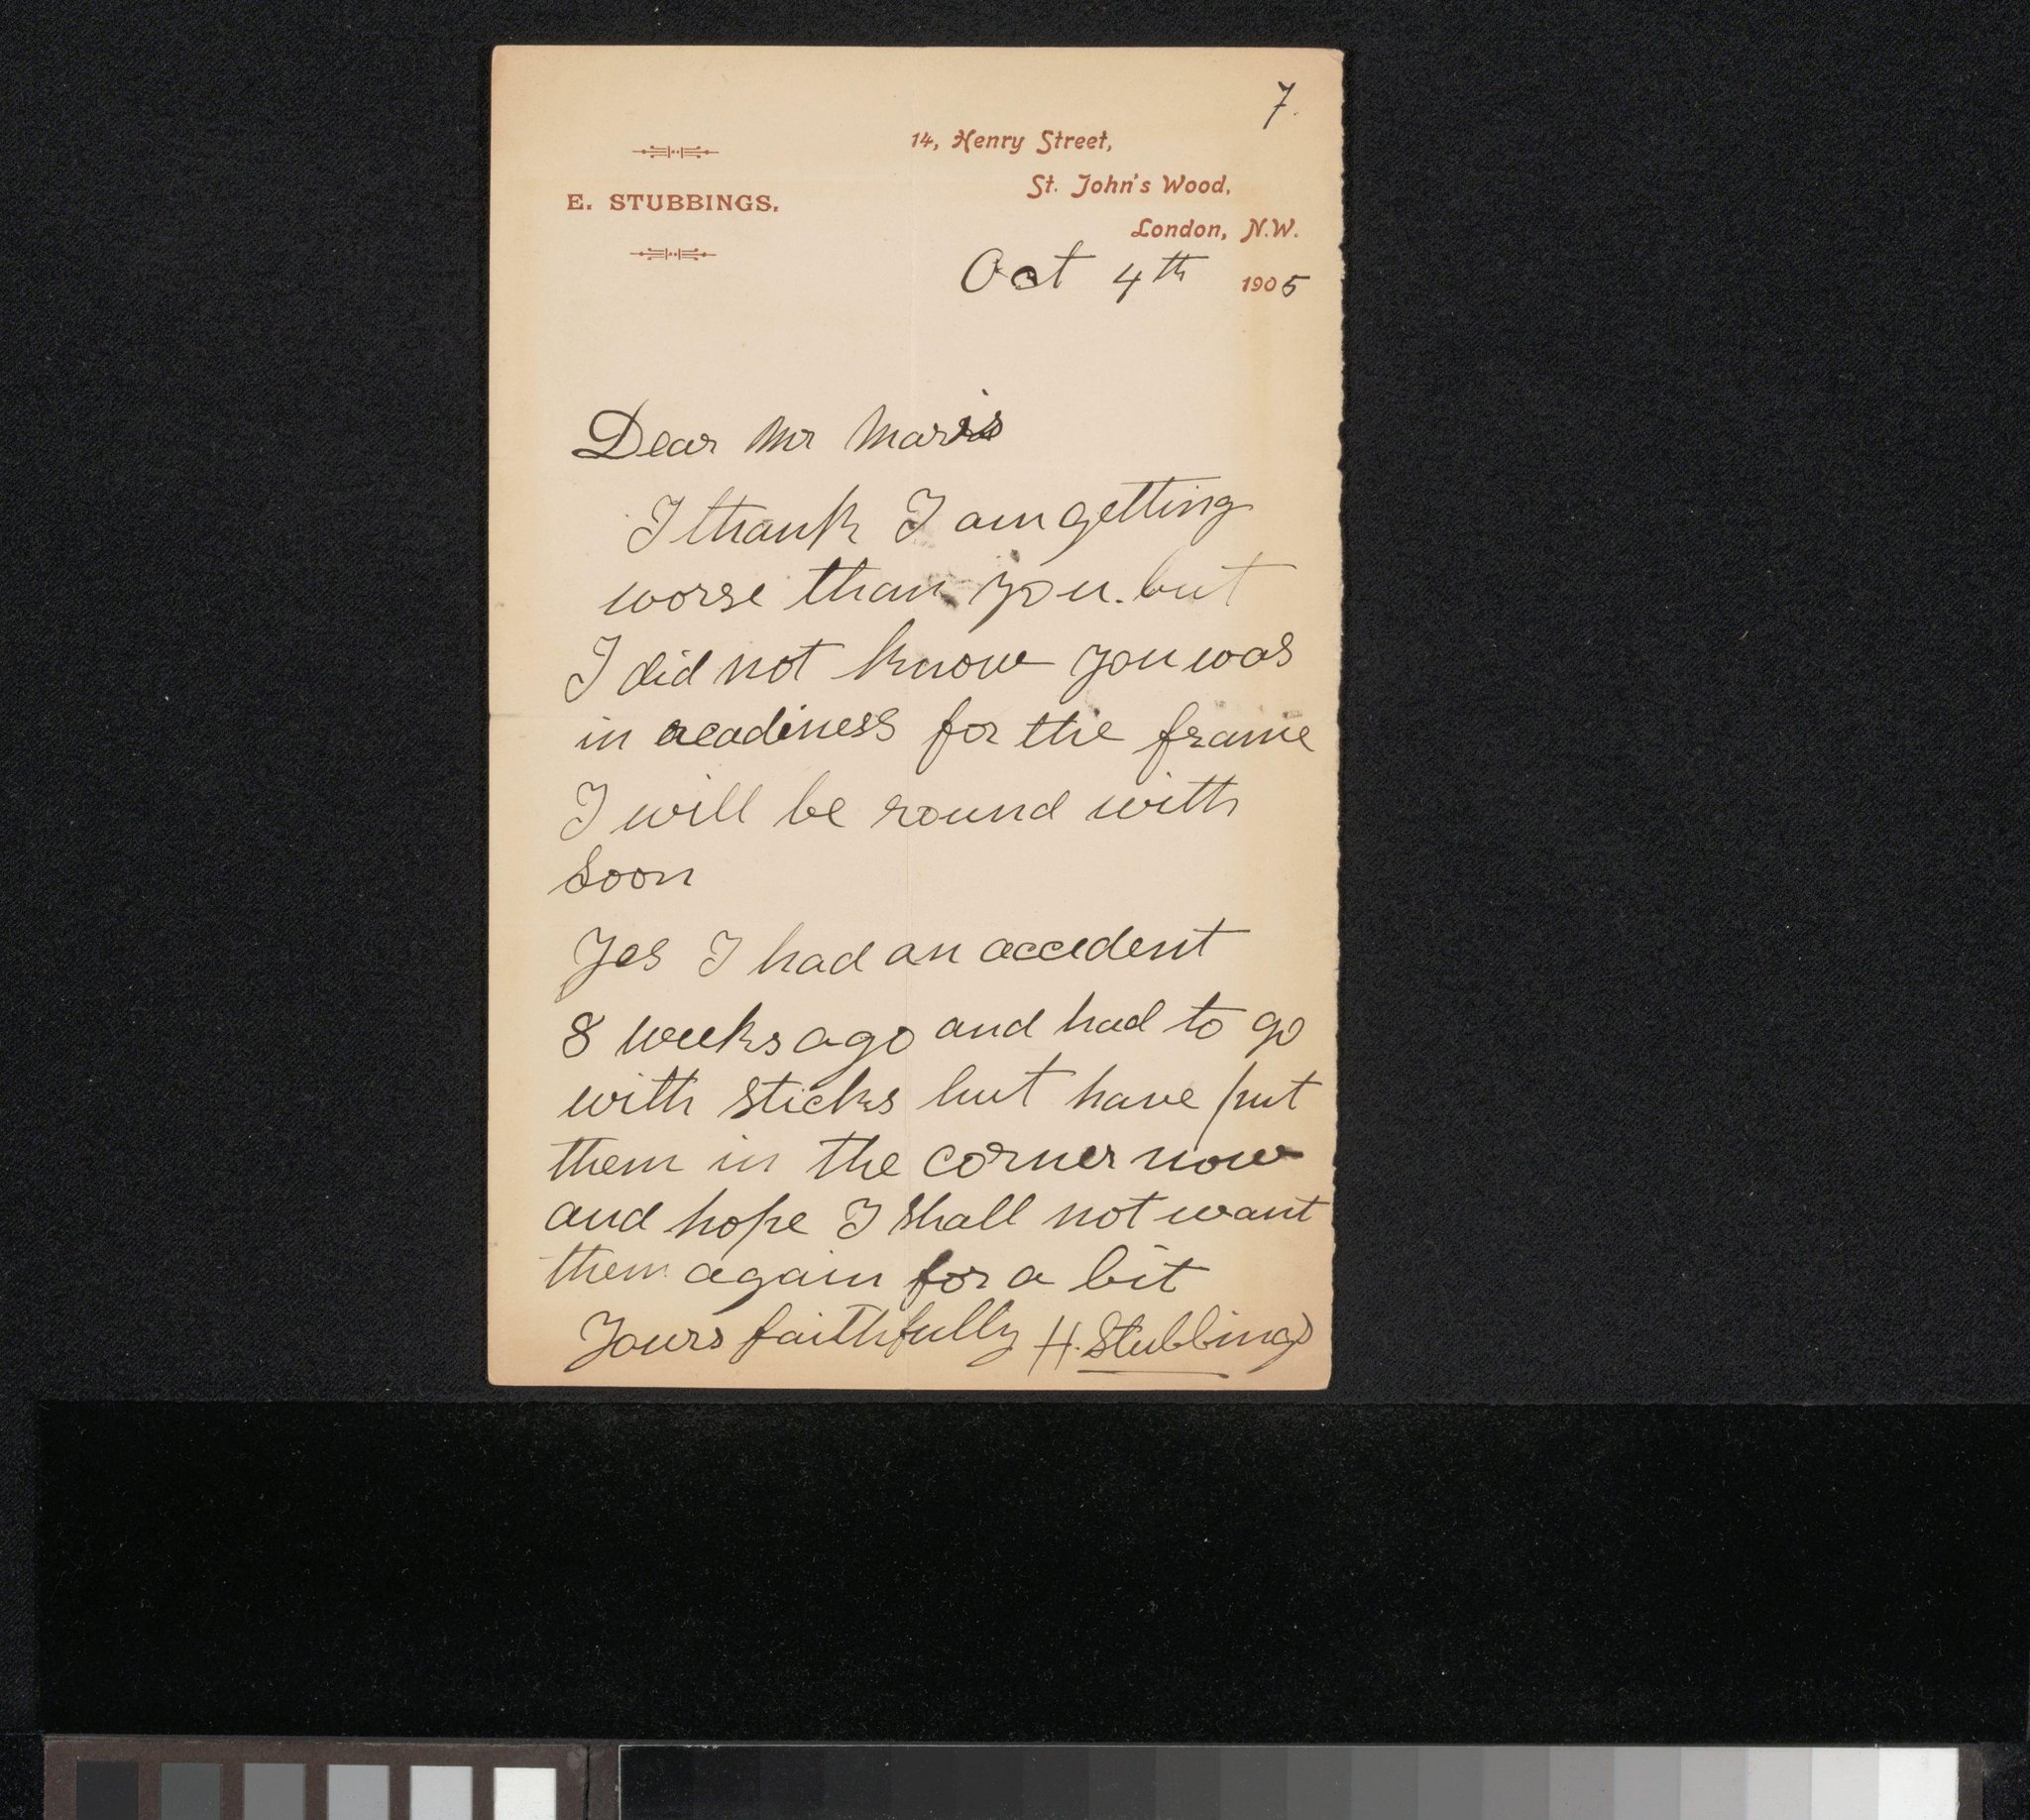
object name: letter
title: Brief aan Matthijs Maris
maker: h. stubbings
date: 1905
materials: ink, paper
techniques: pen, printing, writing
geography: london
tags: the hague, london, painter, print maker, draughtsman, matthijs maris